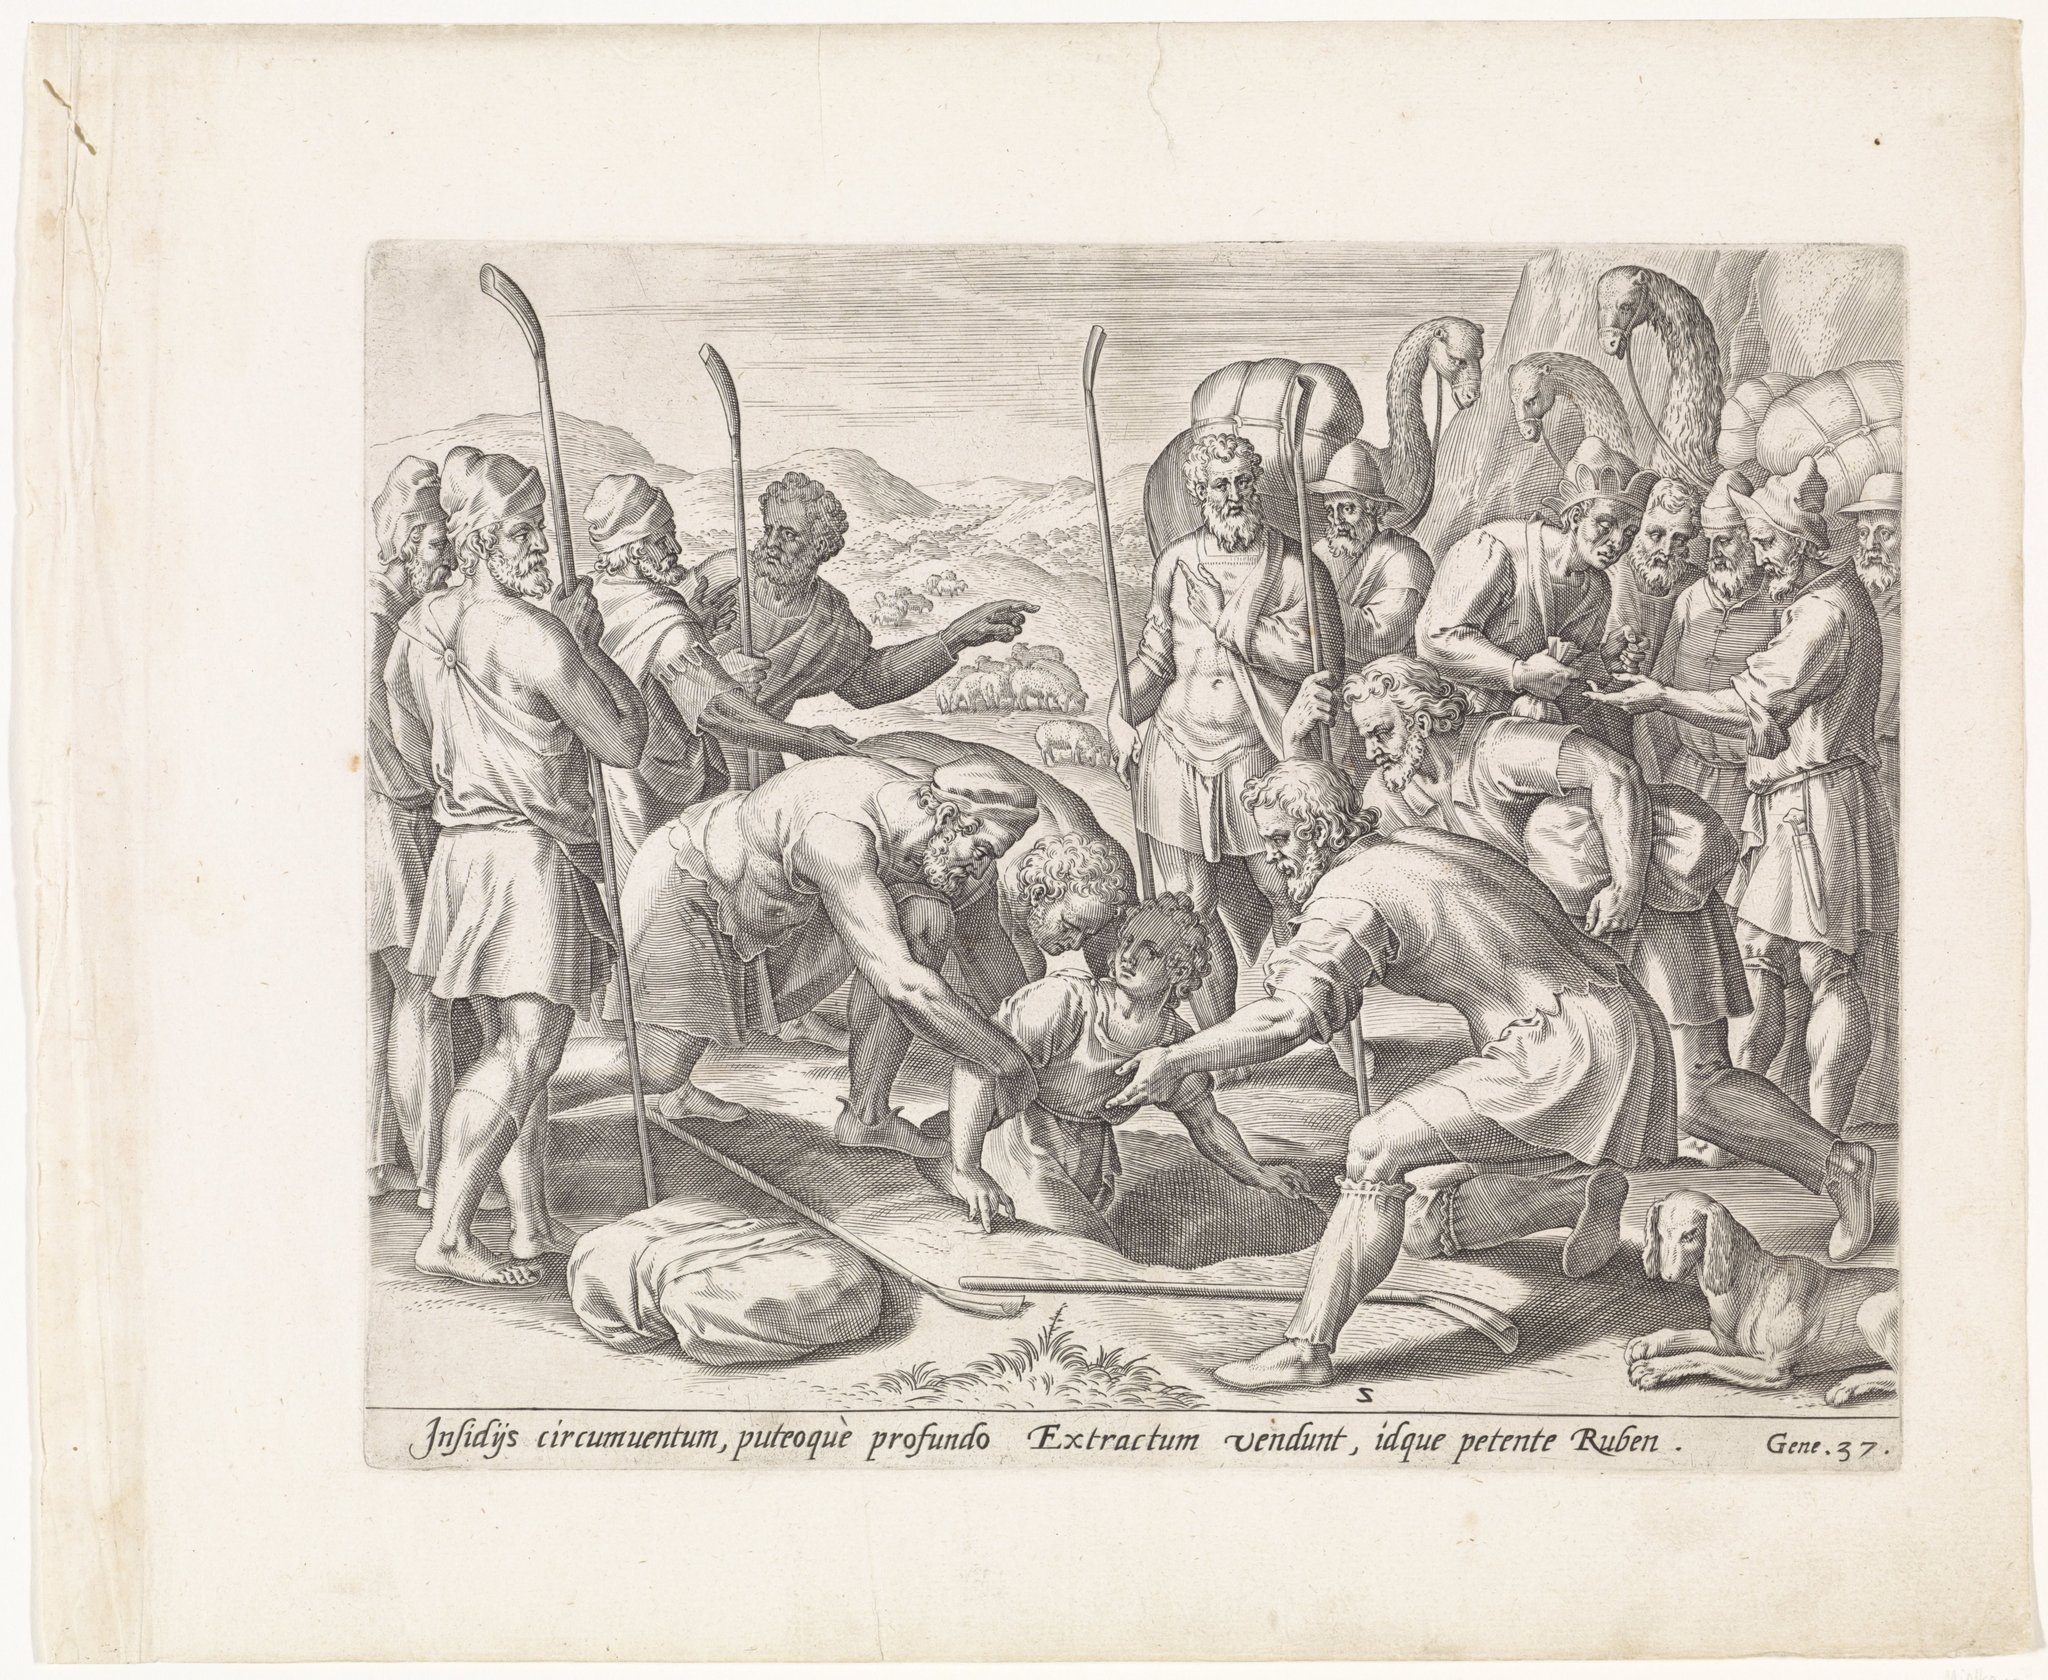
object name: print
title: Geschiedenis van Jozef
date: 1579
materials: paper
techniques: engraving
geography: antwerp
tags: joseph is pulled out of the pit, joseph is sold for twenty pieces of silver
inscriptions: collector's mark: Lugt 2228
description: Prent gebruikt in: Thesaurus sacrarum historiaru[m] veteris (et novi) testame[n]ti, elega[n]tissimis imaginibus expressu[m] excelle[n]tissimoru[m] in hac arte viroru[m] opera : nu[n]c primu[m] in luce[m] editus. Antwerpen: Gerard de Jode, 1585.